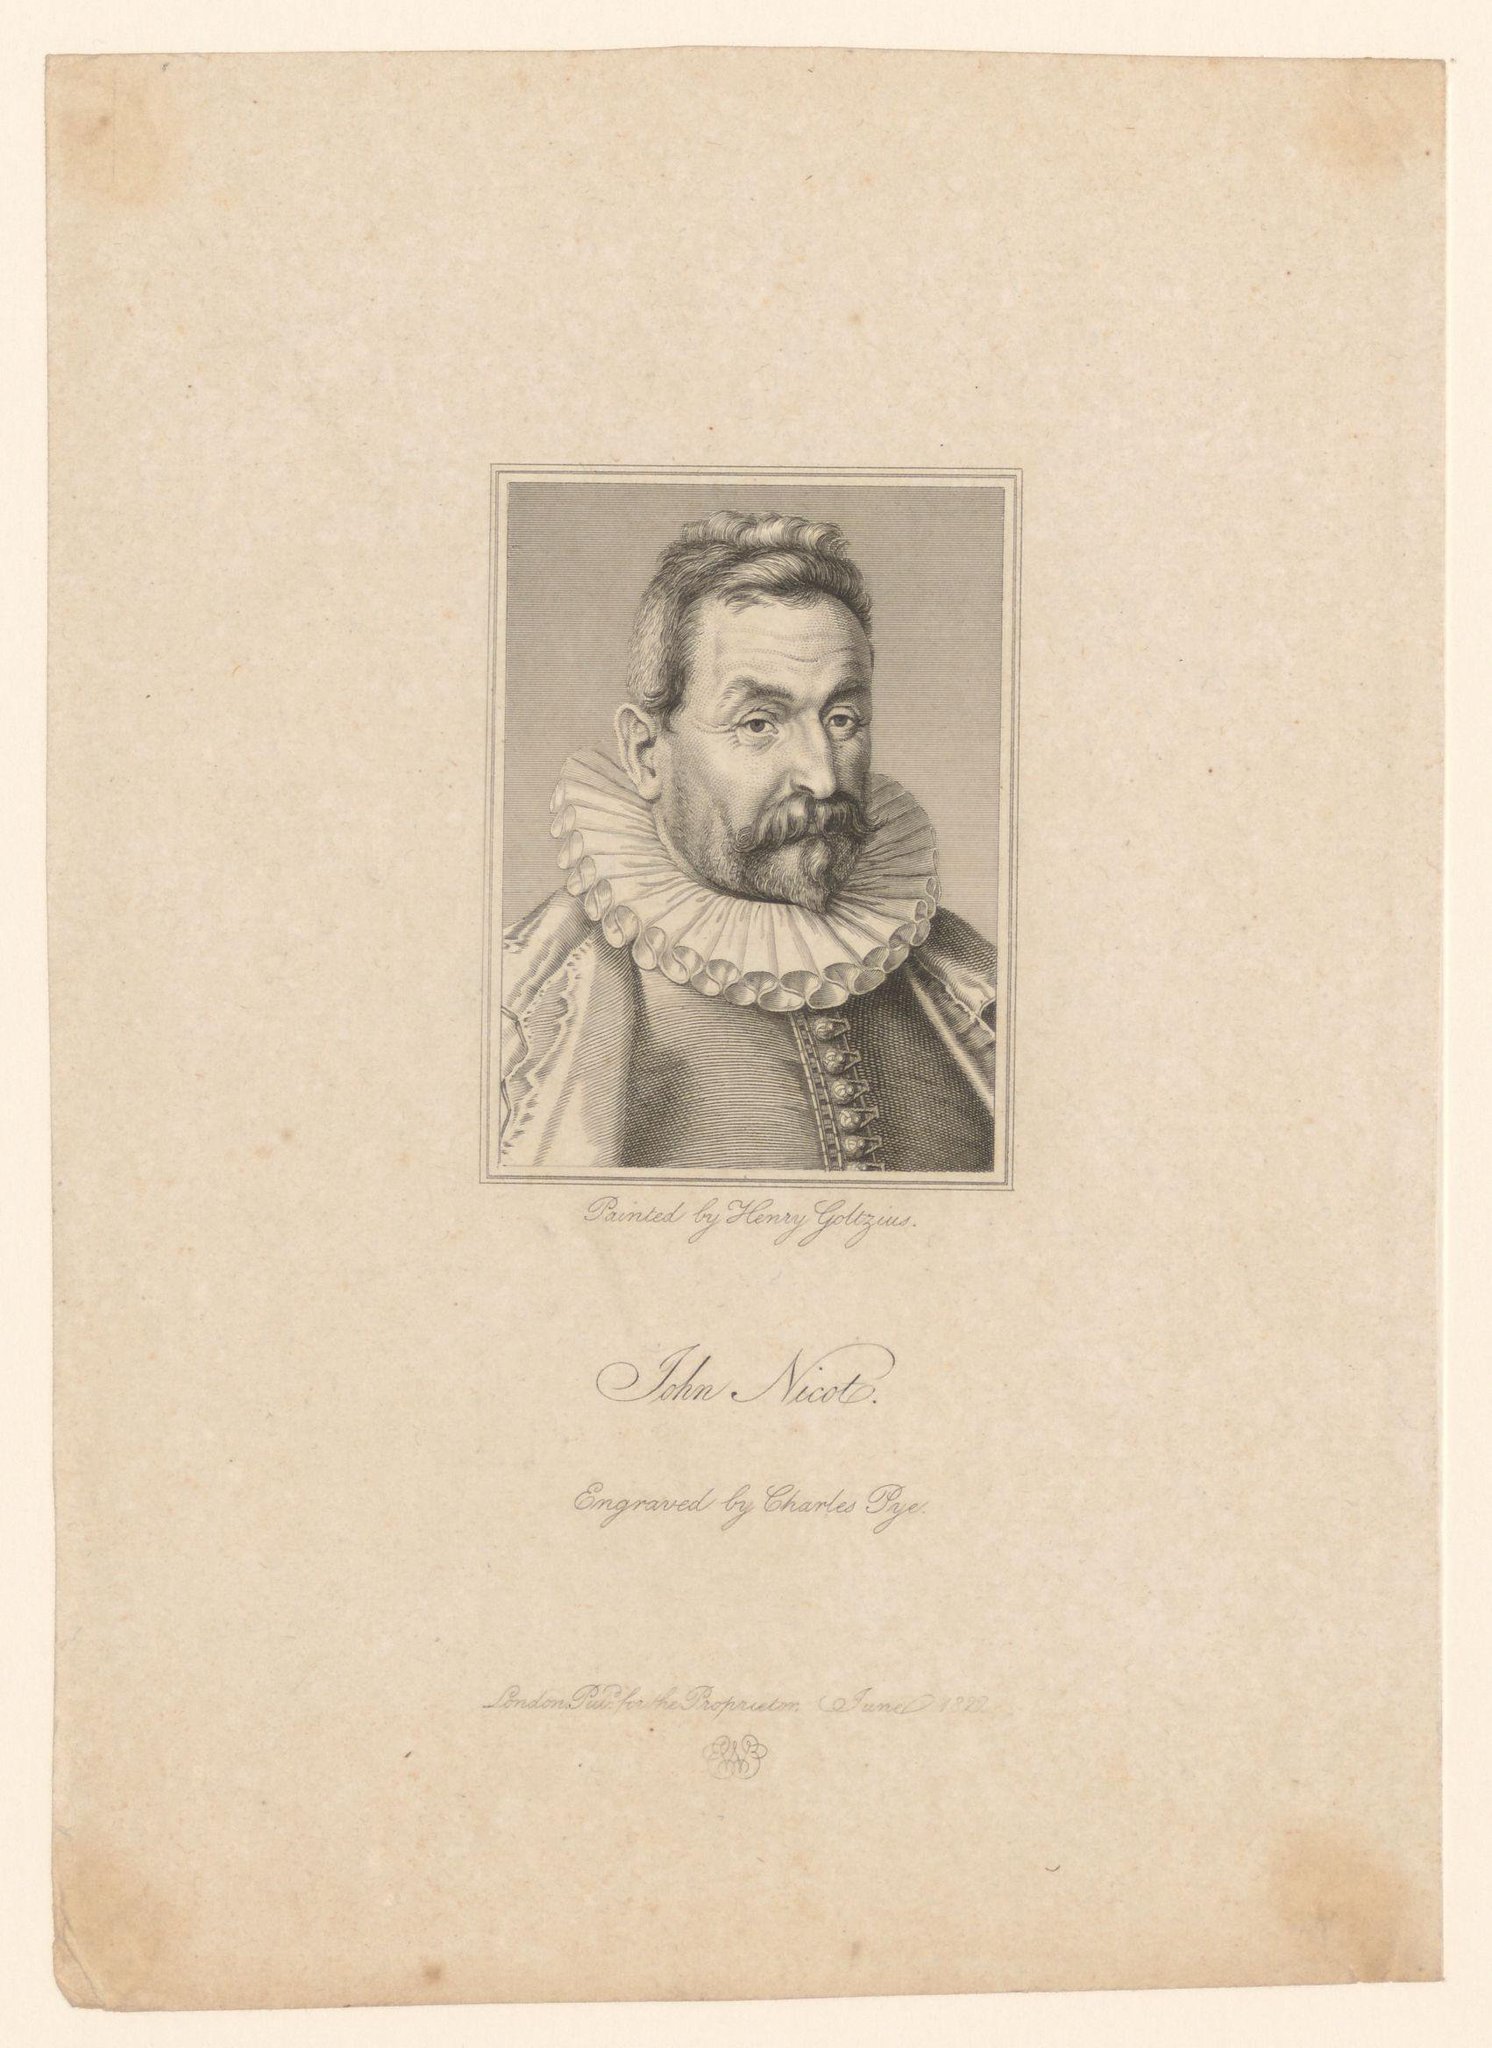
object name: print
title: Portret van Jean Nicot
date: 1822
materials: paper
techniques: engraving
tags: paris, historical persons, diplomacy, diplomat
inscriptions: collector's mark: Lugt 2228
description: Prent gebruikt in: Walmsley, Edward. Physiognomical portraits. Londen: John Major, 1822.